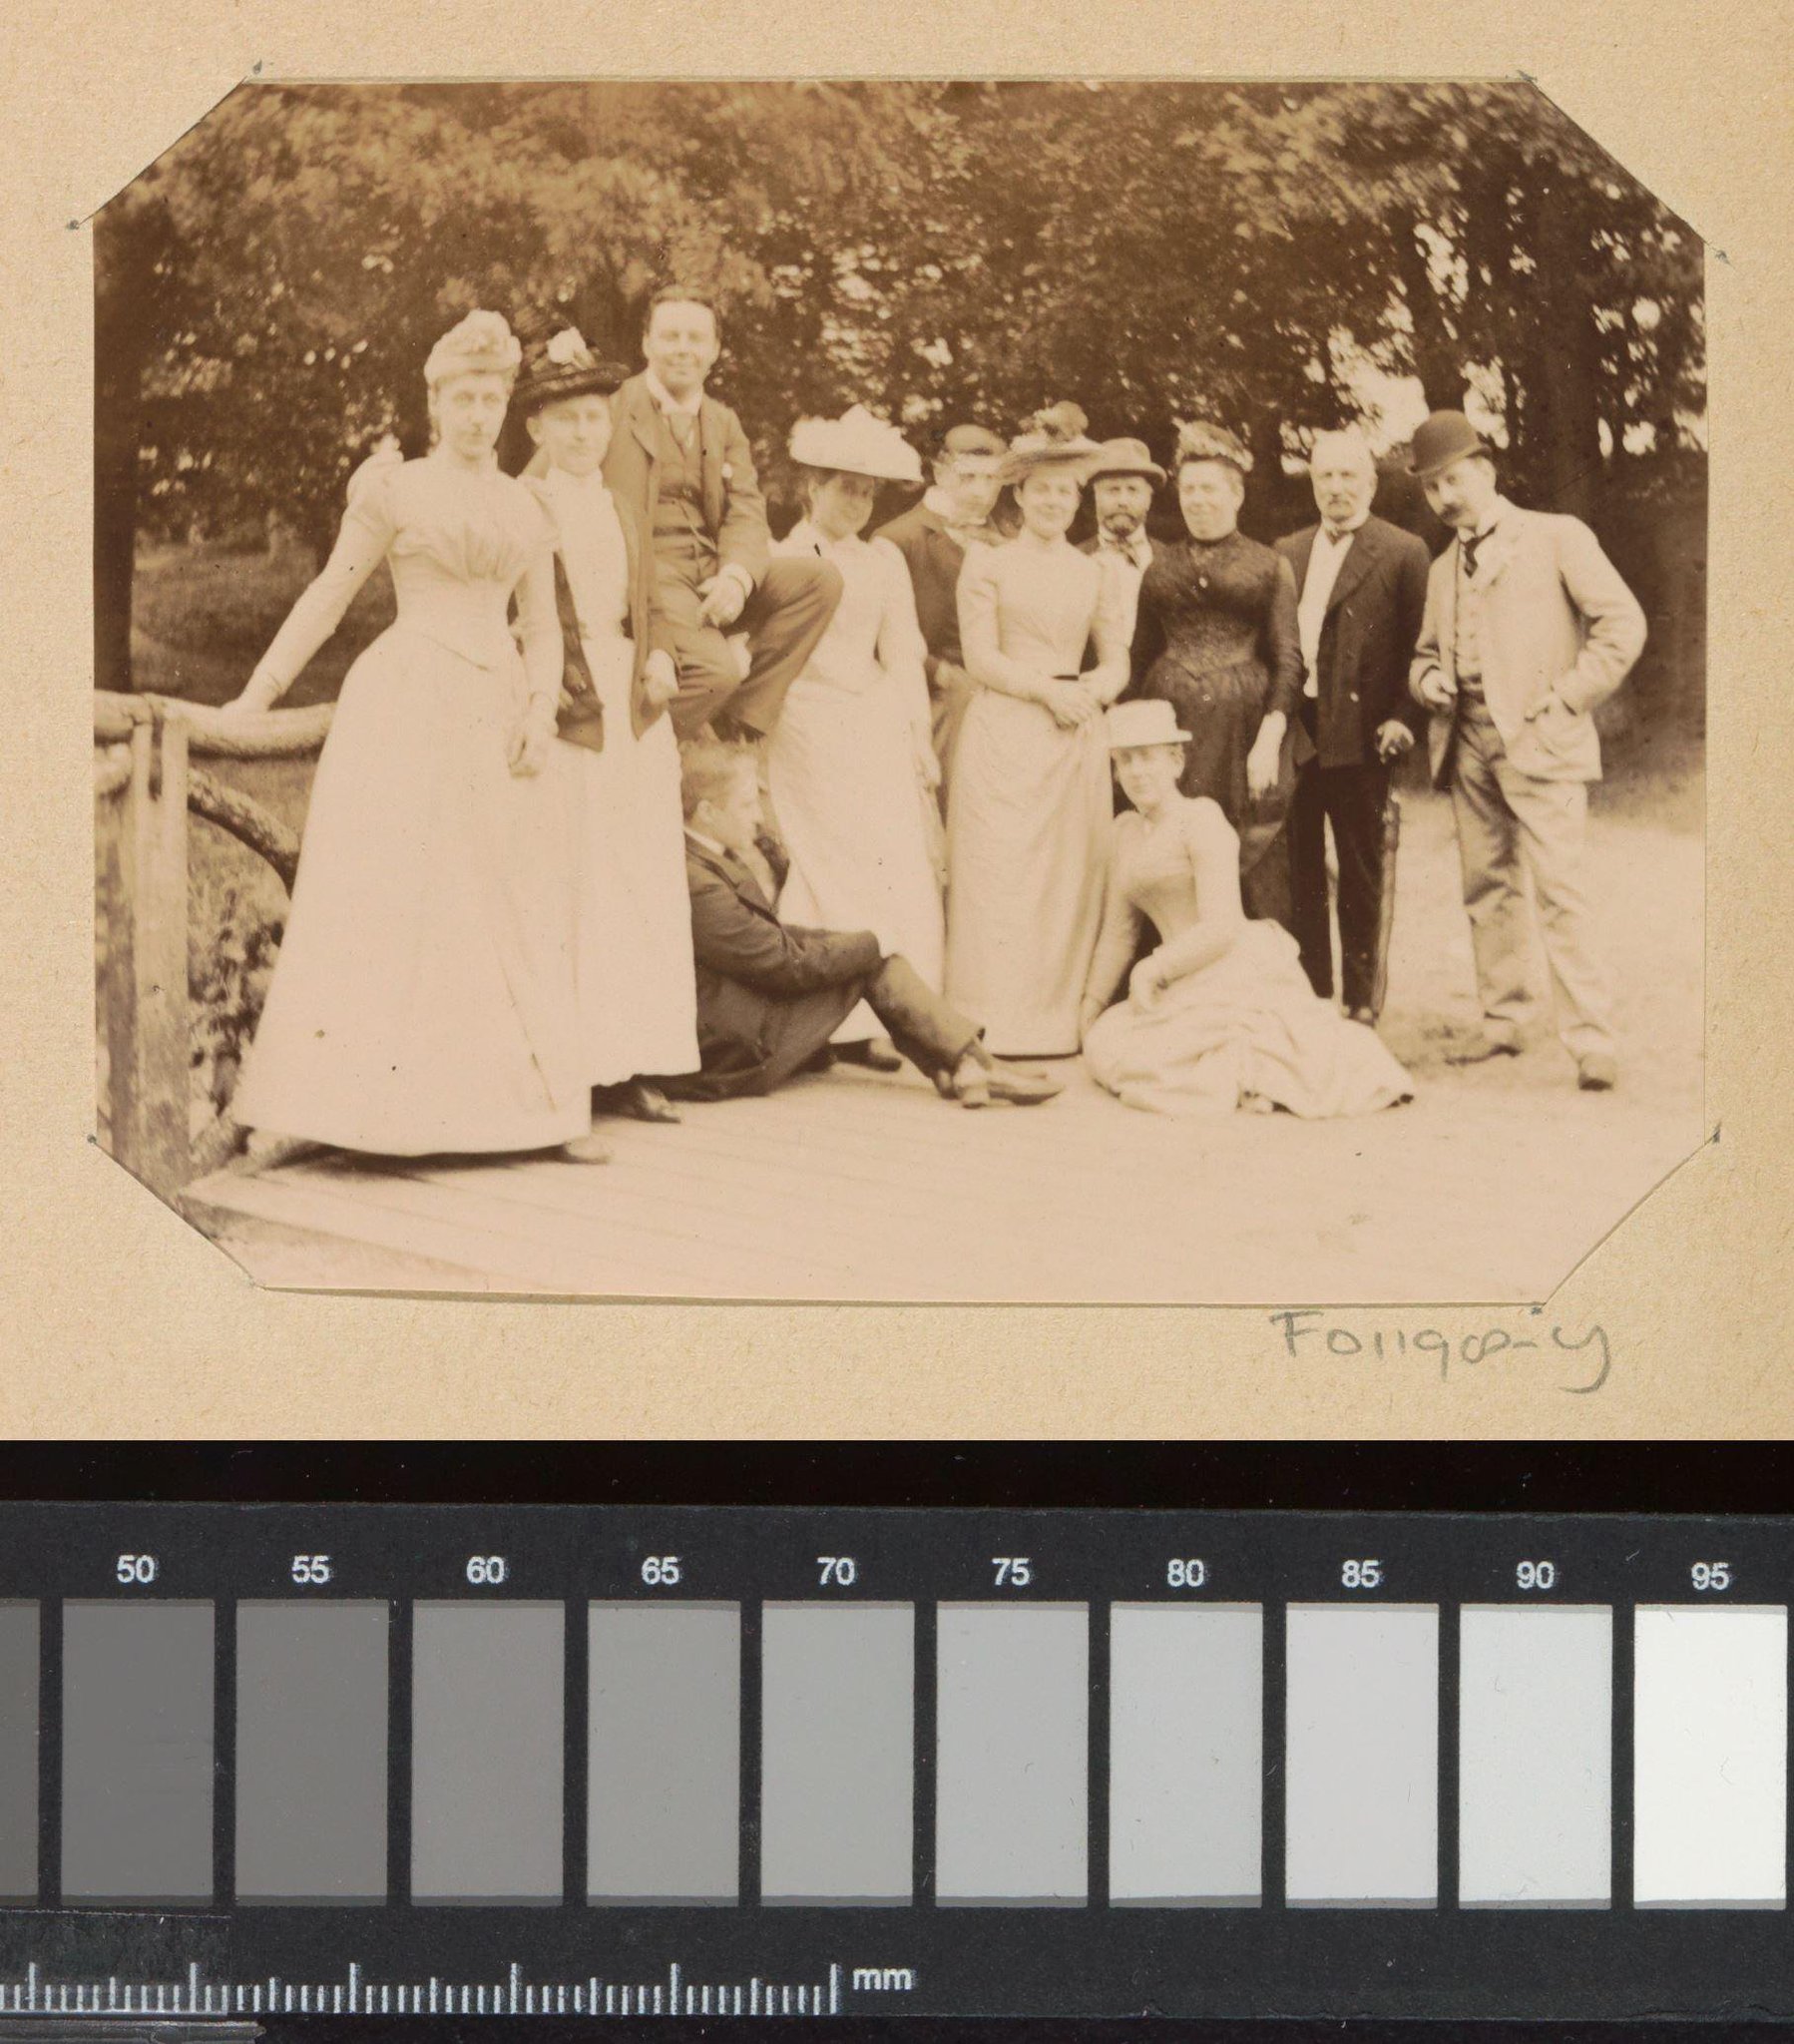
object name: album leaf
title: Groepsportret van de familie Piek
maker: johanna margaretha piek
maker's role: fotograaf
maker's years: 1870-1947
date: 1889-1893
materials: paper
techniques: gelatin silver print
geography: netherlands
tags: family life, anonymous historical persons portrayed in a group, in a group-portrait, netherlands